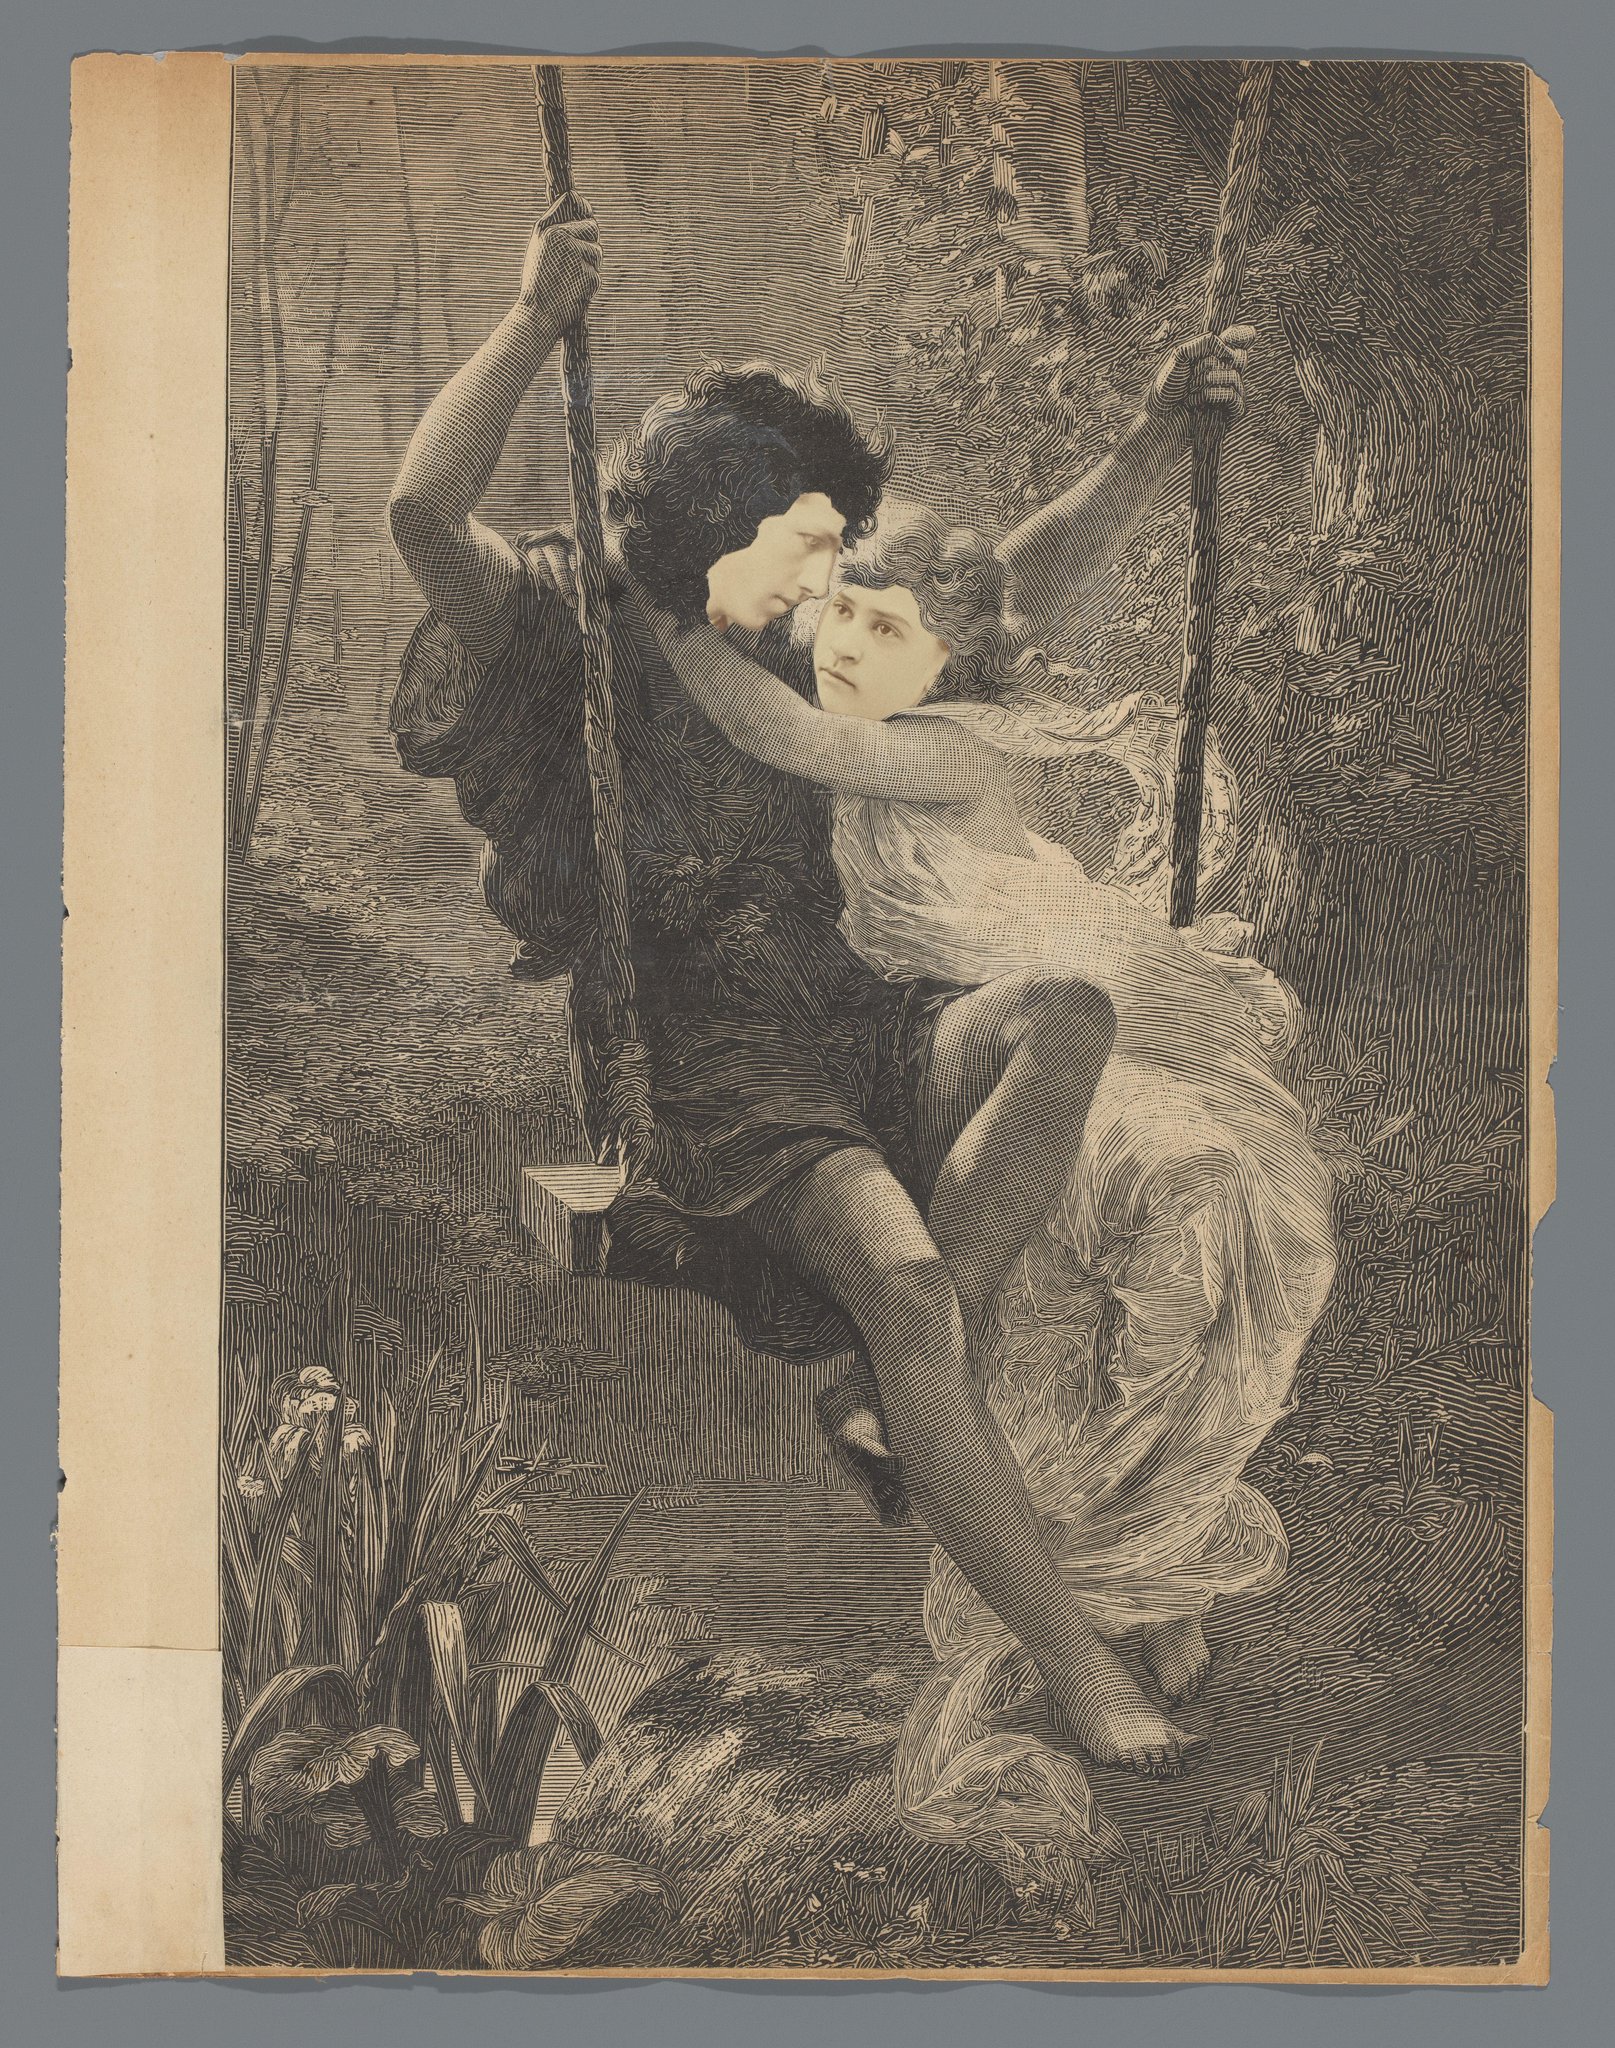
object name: photocollage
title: Paar op de schommel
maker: Anonymous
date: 1873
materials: paper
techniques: albumen print, engraving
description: Collage van 2 albumineportretten op een reproductie in houtgravure van het schilderij 'Springtime' (1873) van Pierre Auguste Cot (1837-1883) in het Metropolitan Museum of Arts in New York.